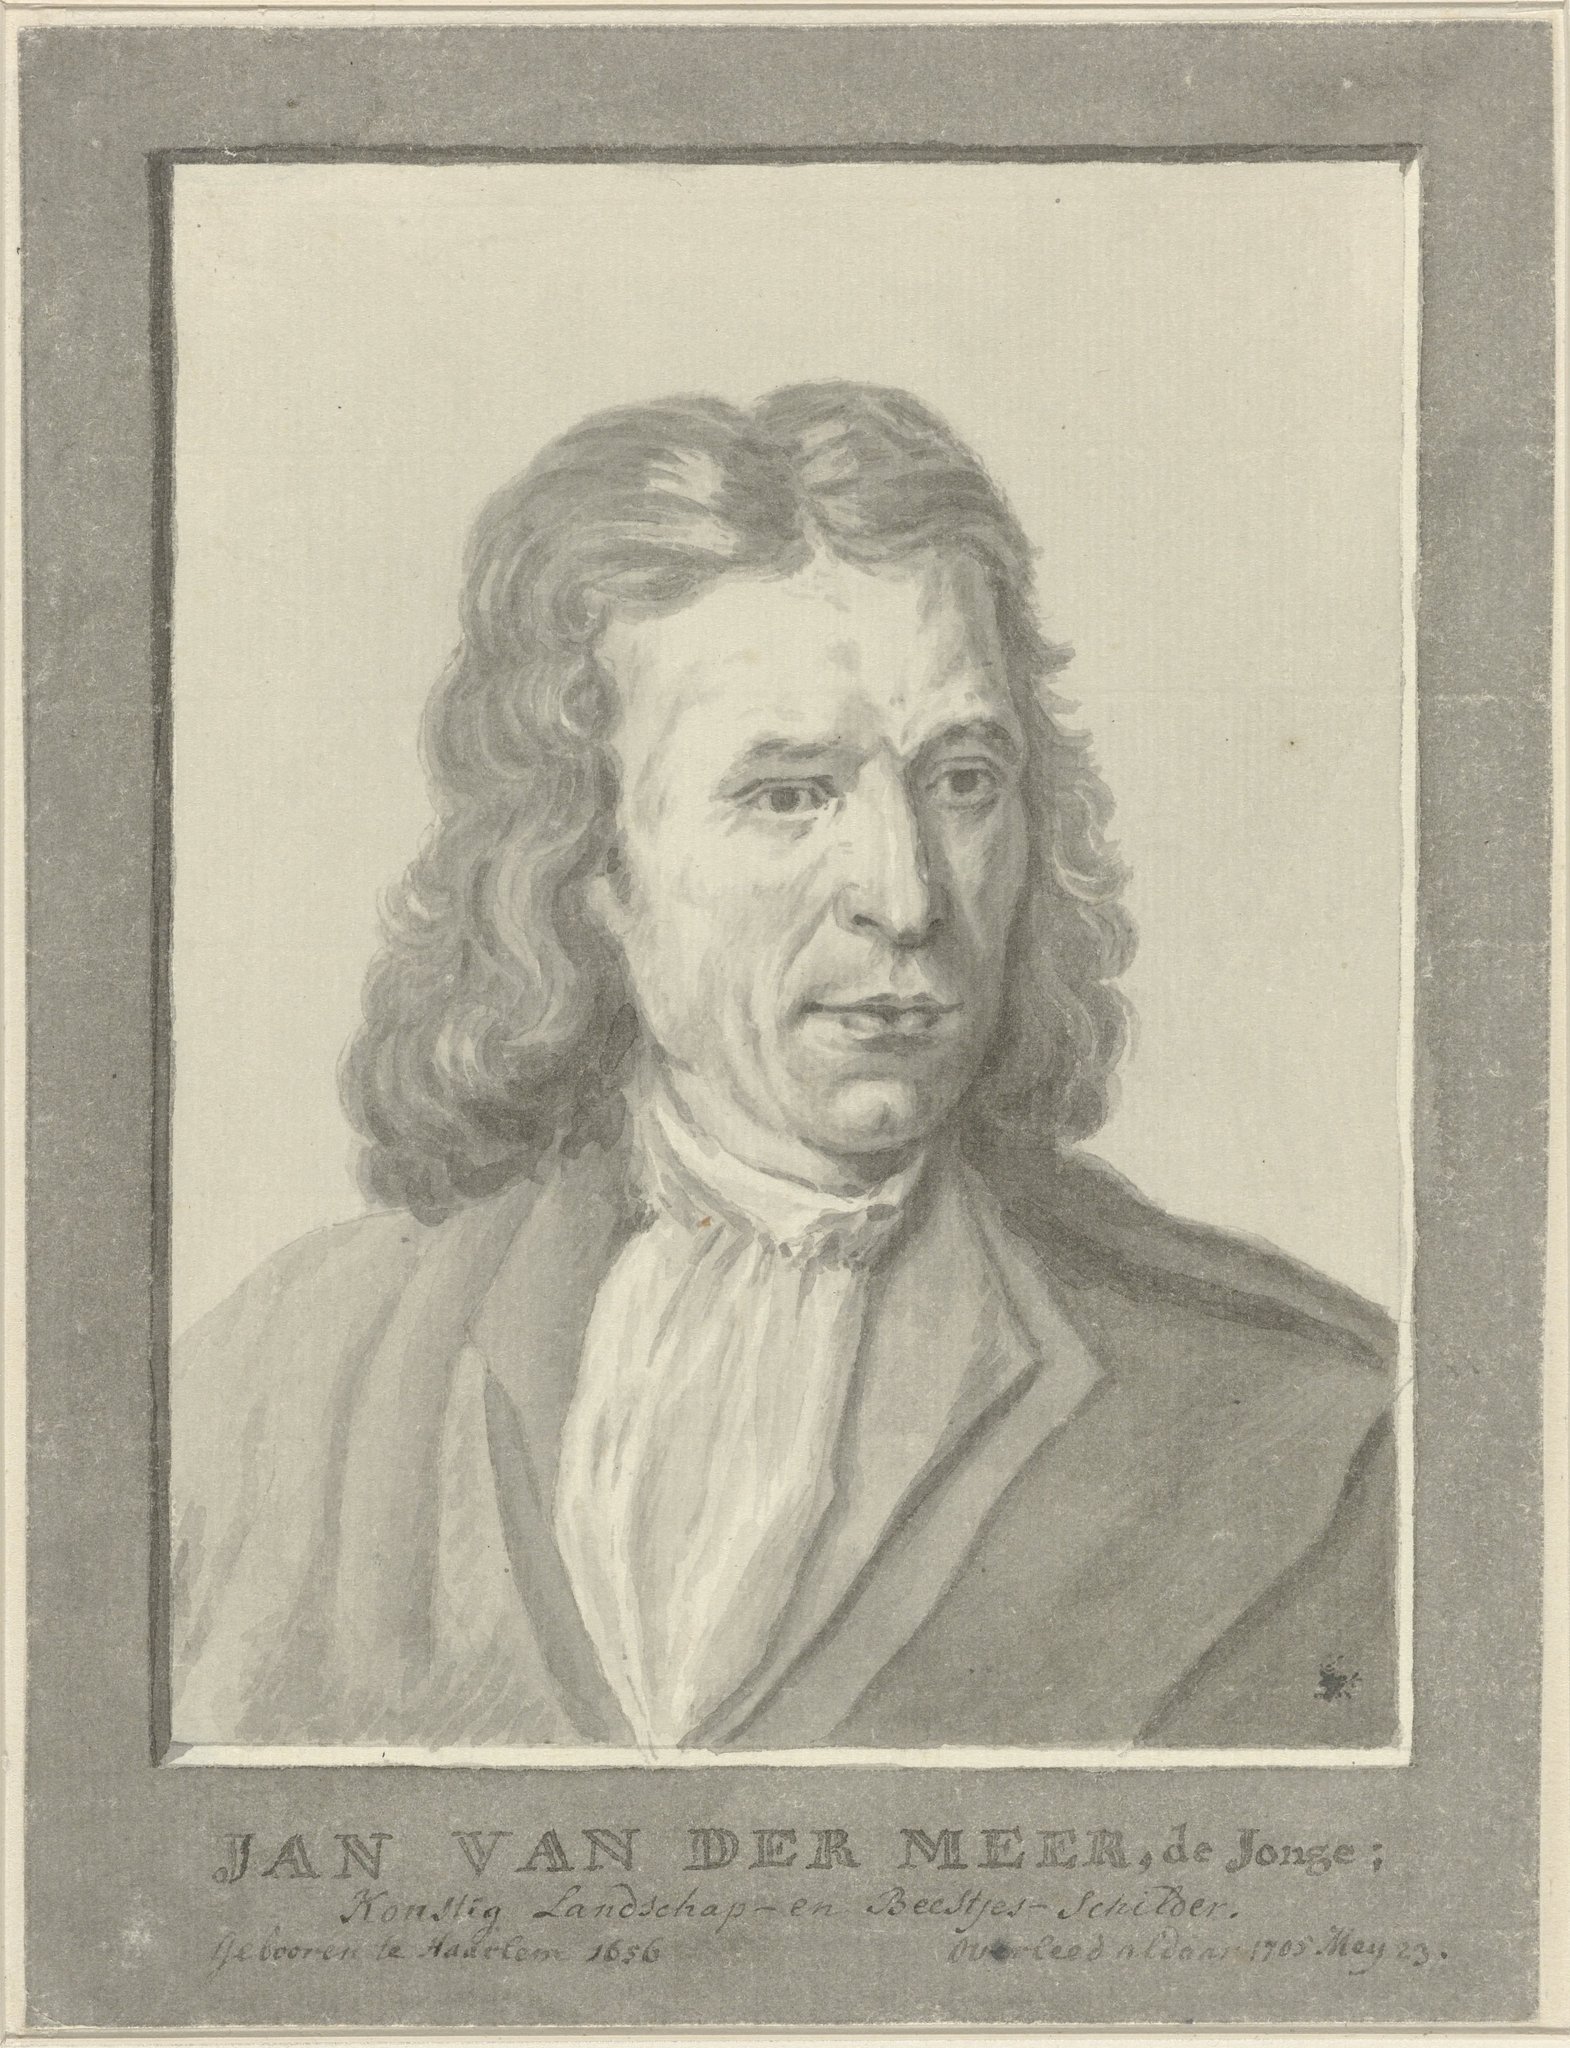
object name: drawing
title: Portret van Johannes van der Meer de Jonge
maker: Anonymous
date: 1757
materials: paper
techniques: brush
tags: print maker, draughtsman, jan van der meer (ii), historical persons, portrait, self-portrait of artist